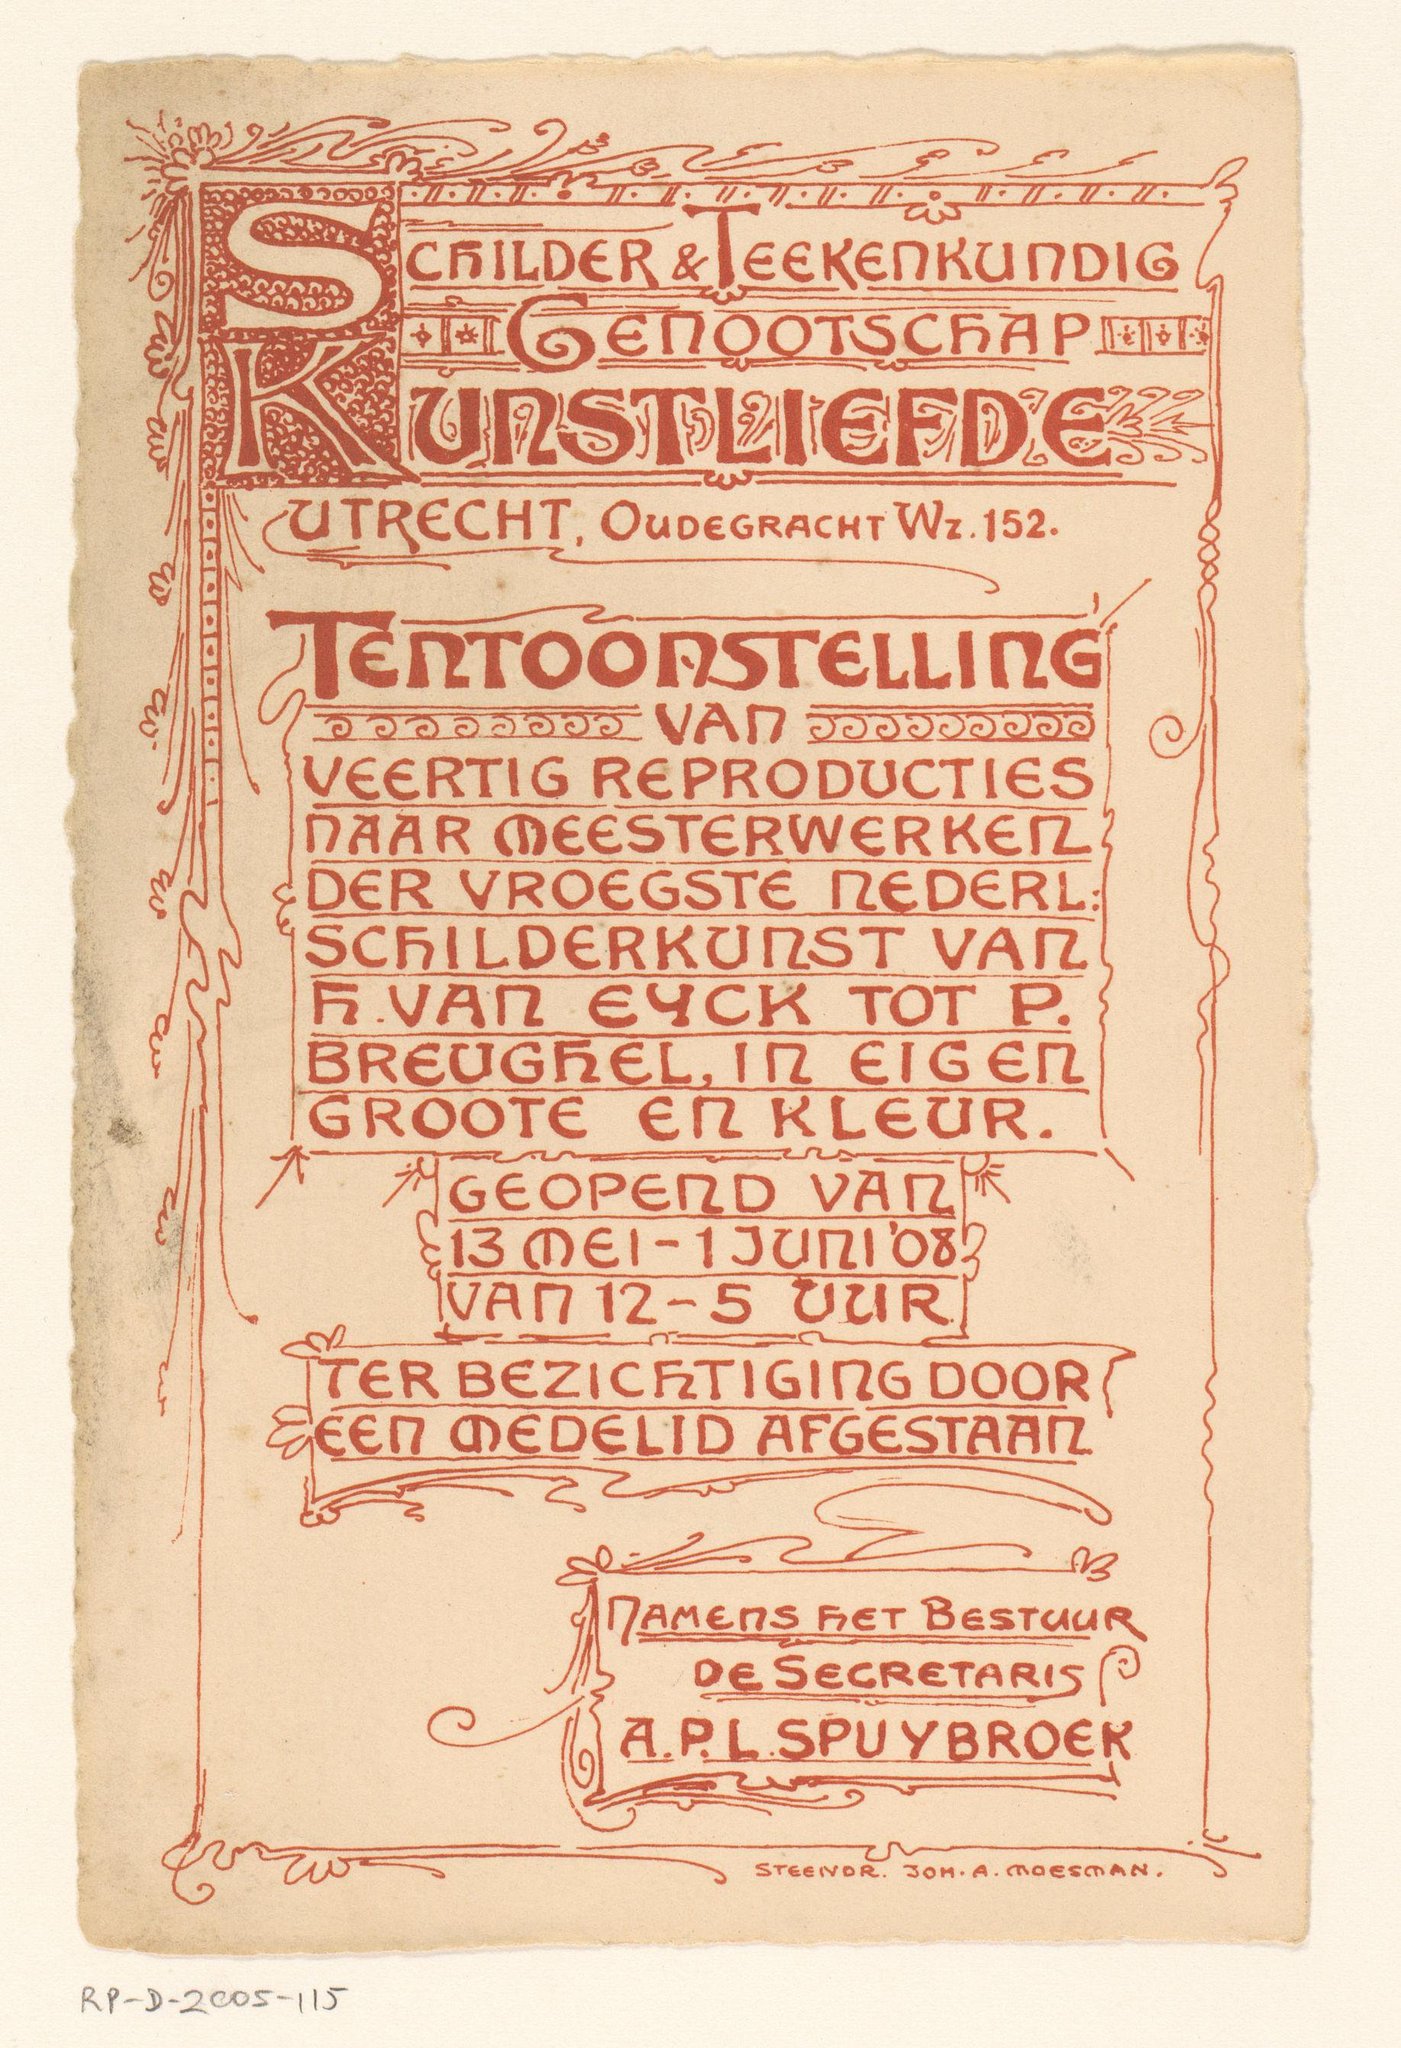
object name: invitation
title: Uitnodiging van Schilder- en Teekenkundig Genootschap "Kunstliefde" voor een tentoonstelling van reproducties, 13 mei - 1 juni 1908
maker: johannes moesman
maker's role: draughtsman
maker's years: 1859-1937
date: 1905-1908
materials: paper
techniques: lithograph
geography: utrecht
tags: criticizing and discussing art, art criticism, circle, club of artists, collecting and exhibiting products of the fine arts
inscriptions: collector's mark: Lugt 2228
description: Blad met tekst met versierde initiaal. Uitnodiging van Schilder- en Teekenkundig Genootschap "Kunstliefde" voor een tentoonstelling van reproducties naar oude Nederlandse schilderkunst, 13 mei - 1 juni 1908.